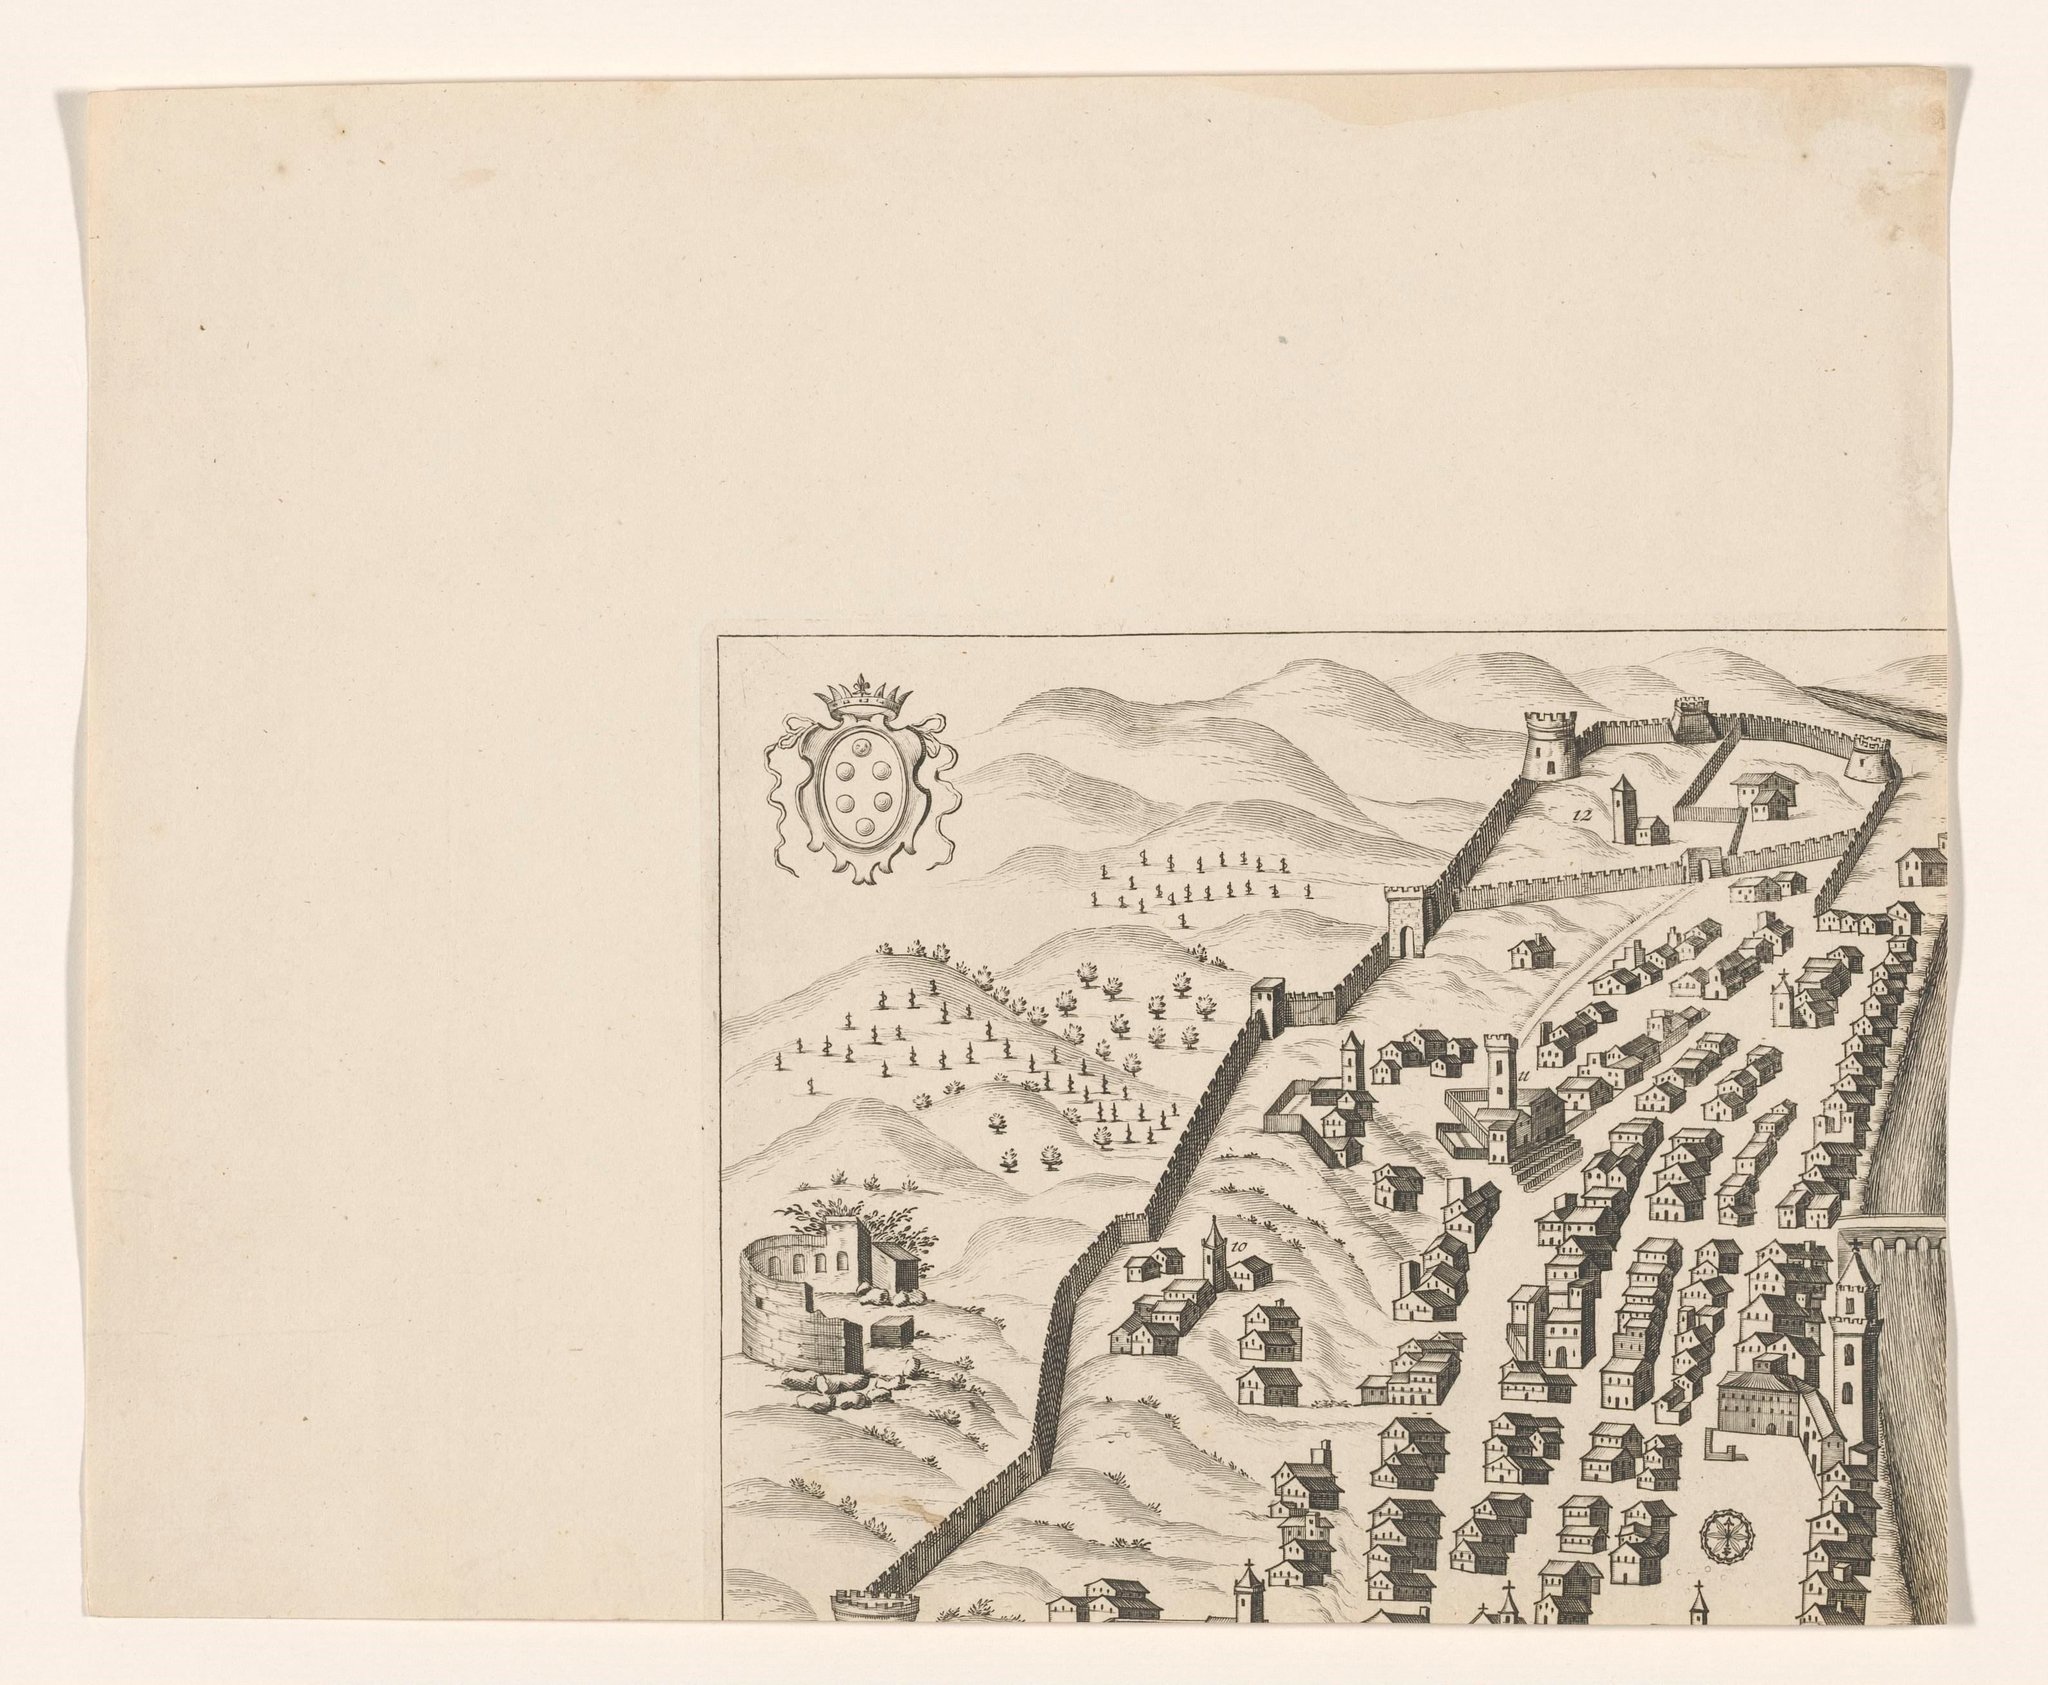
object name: print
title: Plattegrond van een Italiaanse stad (deel linksboven)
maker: Anonymous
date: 1600-1699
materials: paper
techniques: engraving, etching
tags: maps of cities, prospect of city, town panorama, silhouette of city, italy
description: Plattegrond van een Italiaanse stad, gesneden in vier delen. Linksboven het wapen van de' Medici.